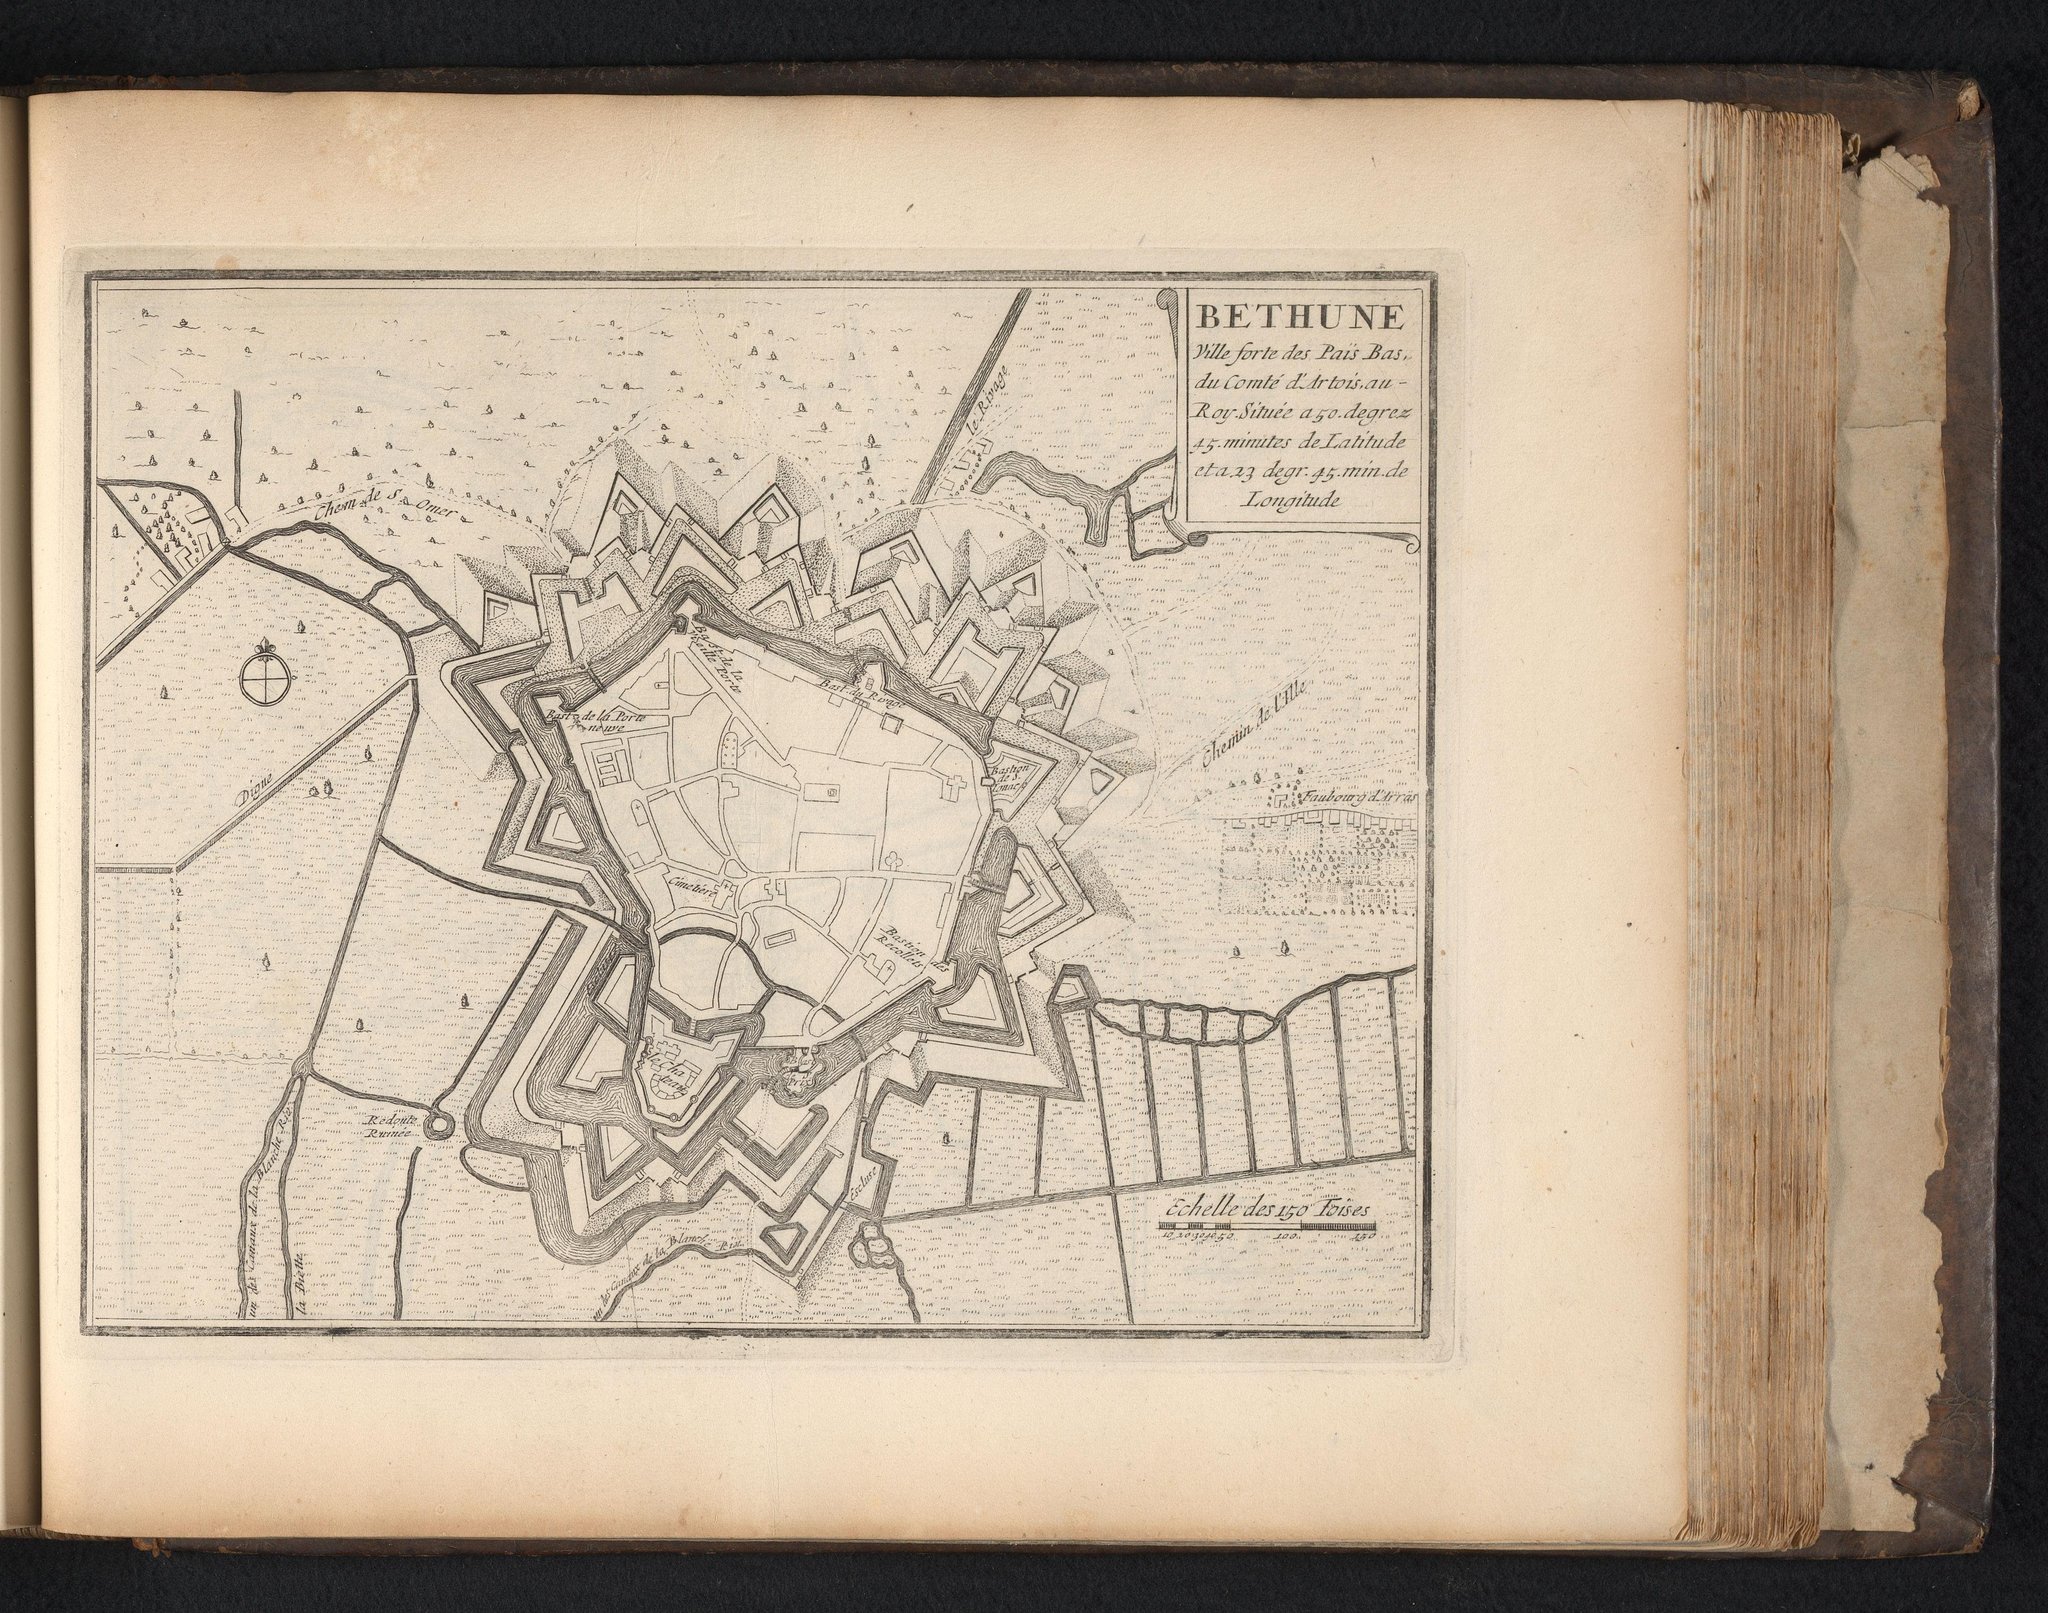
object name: map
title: Bethune Ville forte des Pais-Bas, du Comté d'Artois (...)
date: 1695-1697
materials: paper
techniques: etching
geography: france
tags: fortress, maps of cities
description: Plattegrond van de versterkingen om de stad Béthune in Artois. Onderdeel van het achtste deel (1697) van het prentwerk waarin gebundeld zijn de acht delen van Les forces de l'Europe uitgegeven tussen 1693-1697. Het prentwerk bestaat uit 175 platen met plannen (afkomstig van Sébastien Le Prestre, Seigneur de Vauban) van vermaarde sterke steden en vestingen in de Negenjarige Oorlog. Titel en opschriften in het Frans.